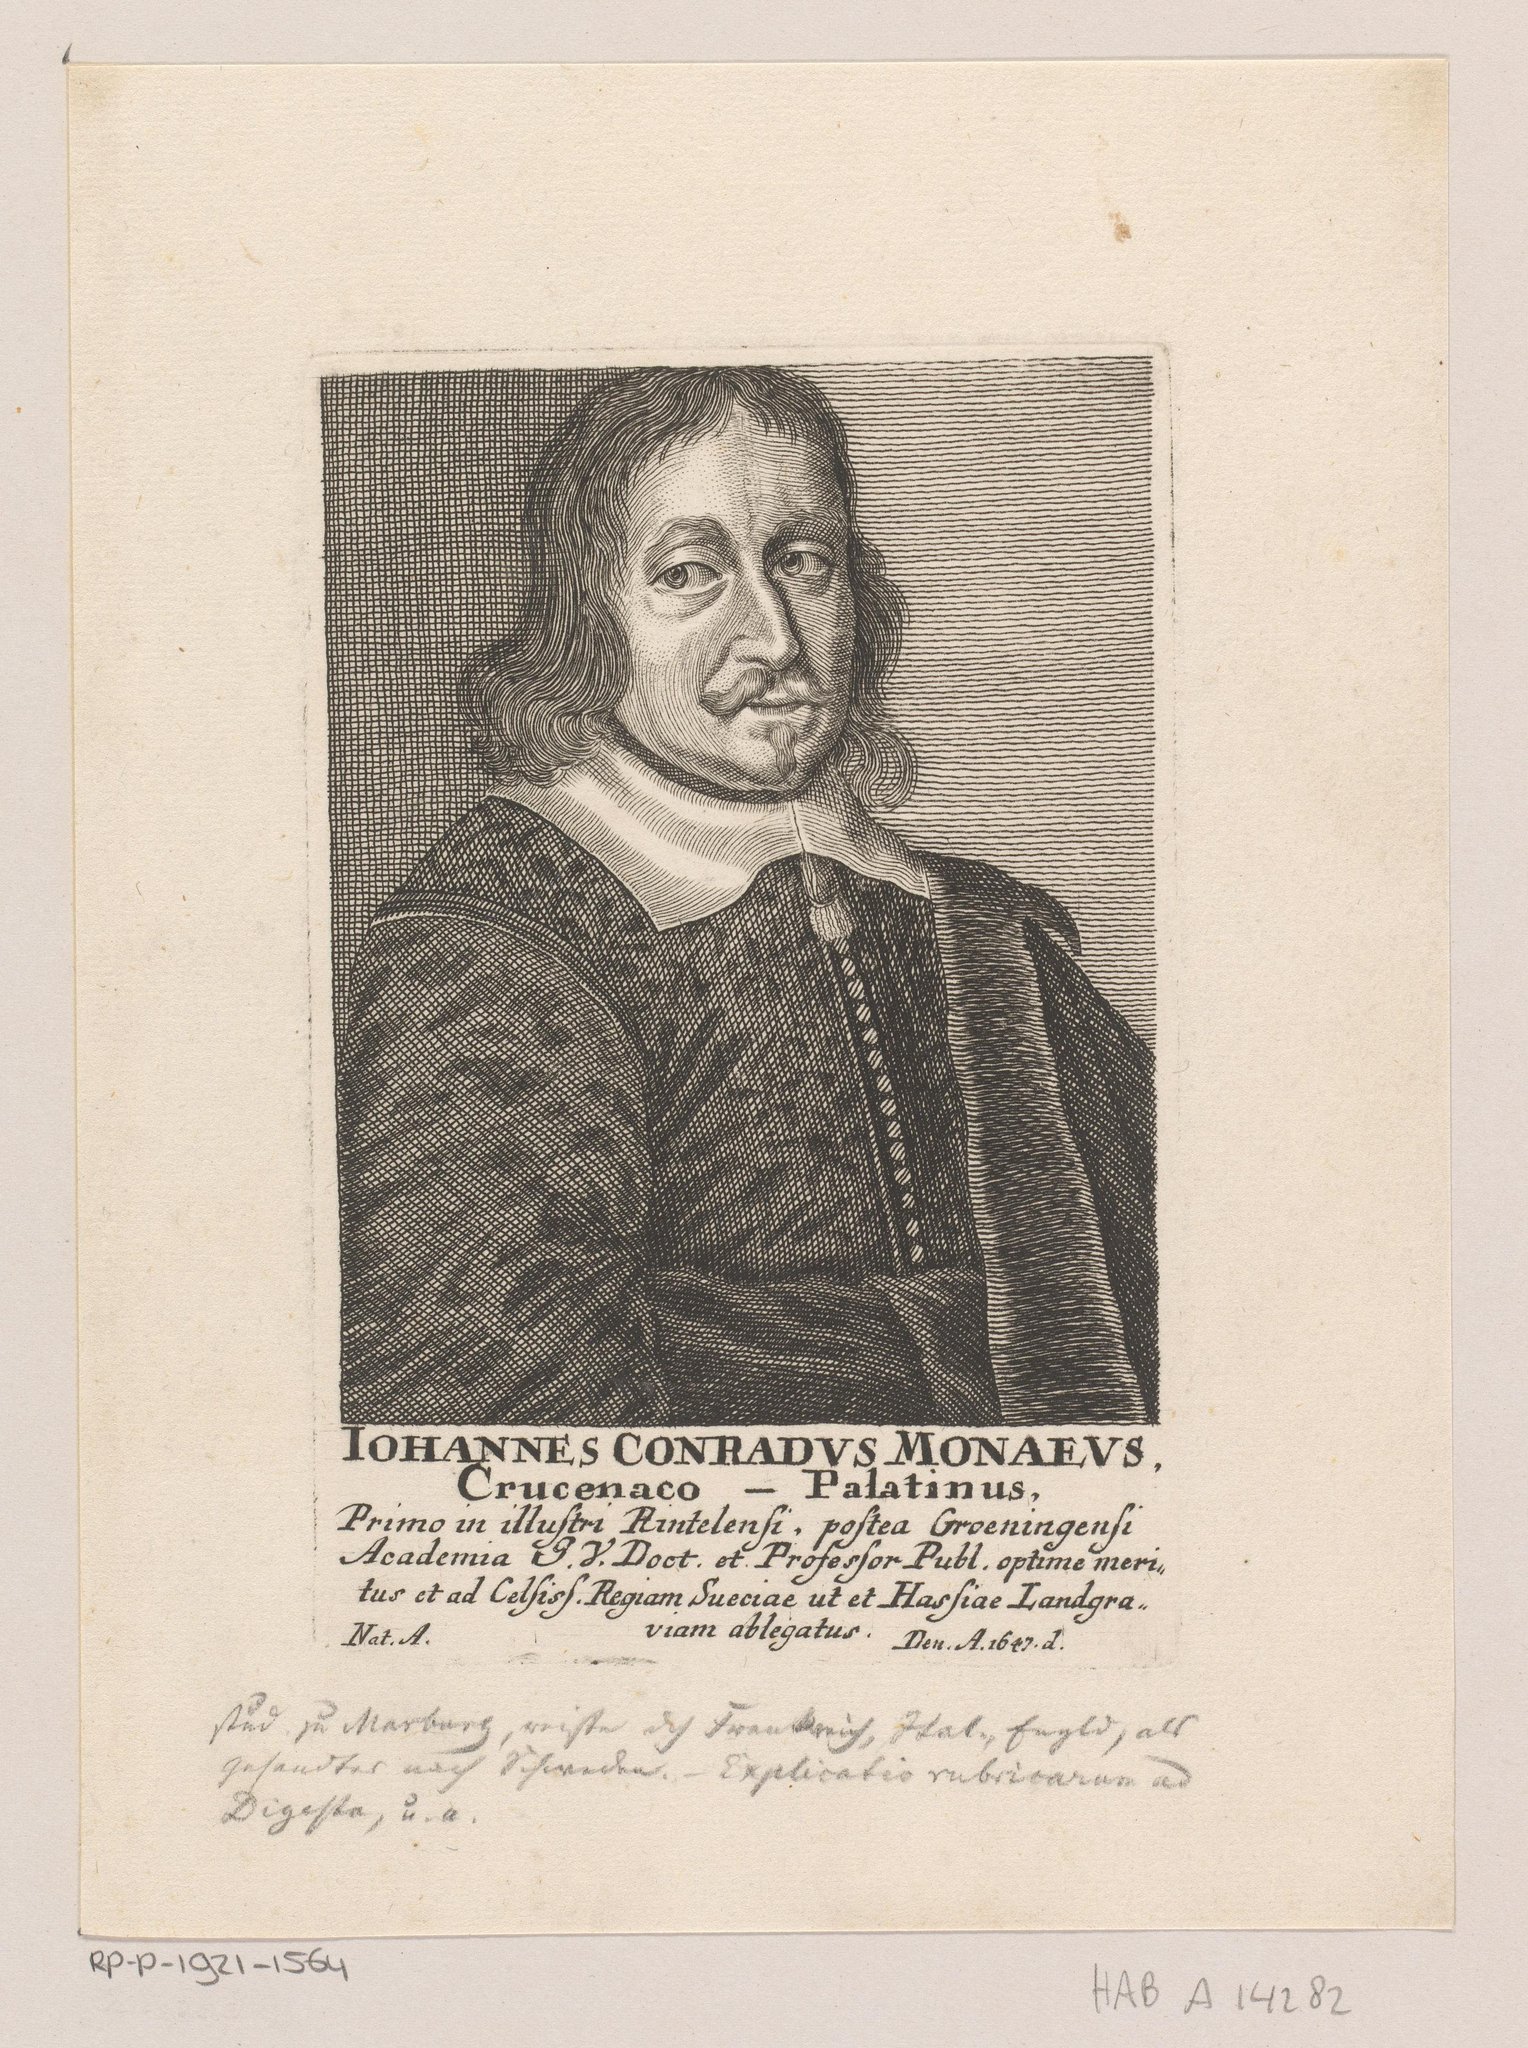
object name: print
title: Iohannes Conradus Monaeus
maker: Anonymous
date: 1647-1750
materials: paper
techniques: engraving, etching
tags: historical persons, professor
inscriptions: collector's mark: Lugt 2233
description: Met vierregelig onderschrift in het Latijn.